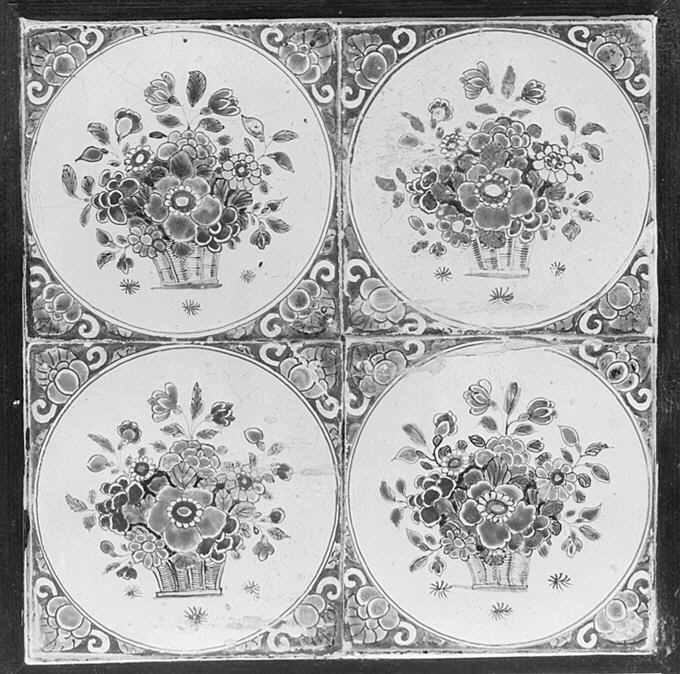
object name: tile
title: Tiles (4)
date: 1734-1766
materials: earthenware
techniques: glazing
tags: flowers